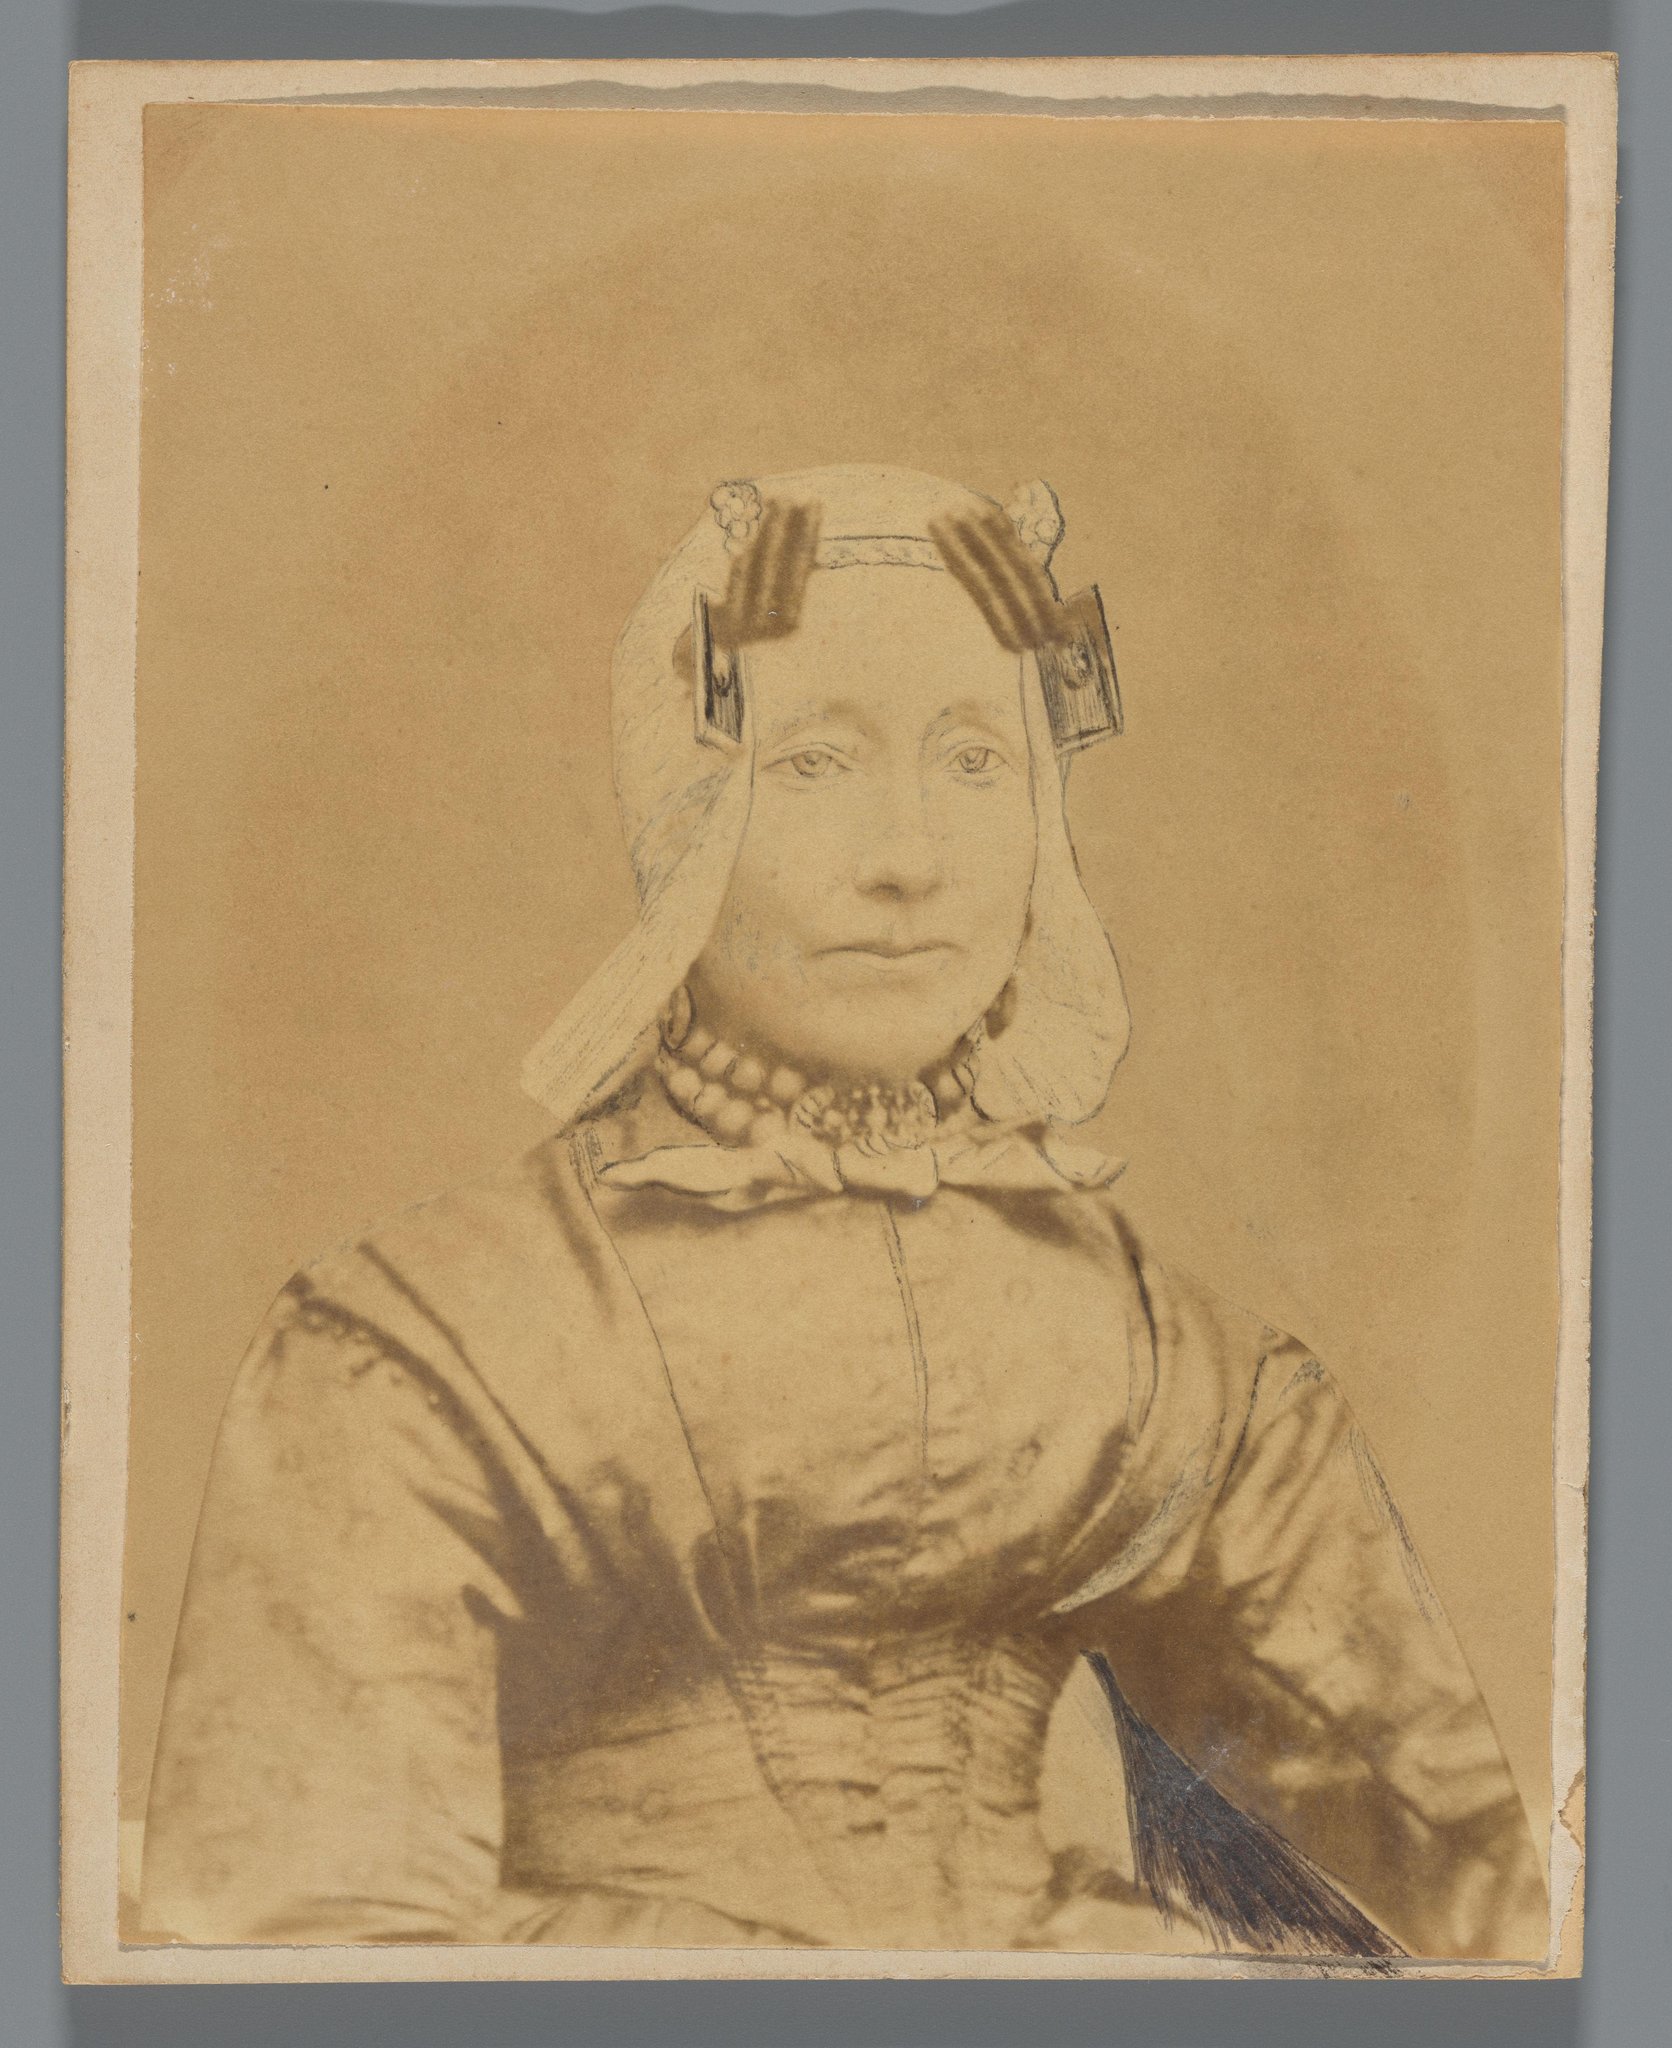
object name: photograph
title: Portret van een onbekende vrouw met muts en oorijzers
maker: Anonymous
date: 1851-1900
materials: cardboard, paper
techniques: albumen print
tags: historical persons - bb - woman, head-gear: cap